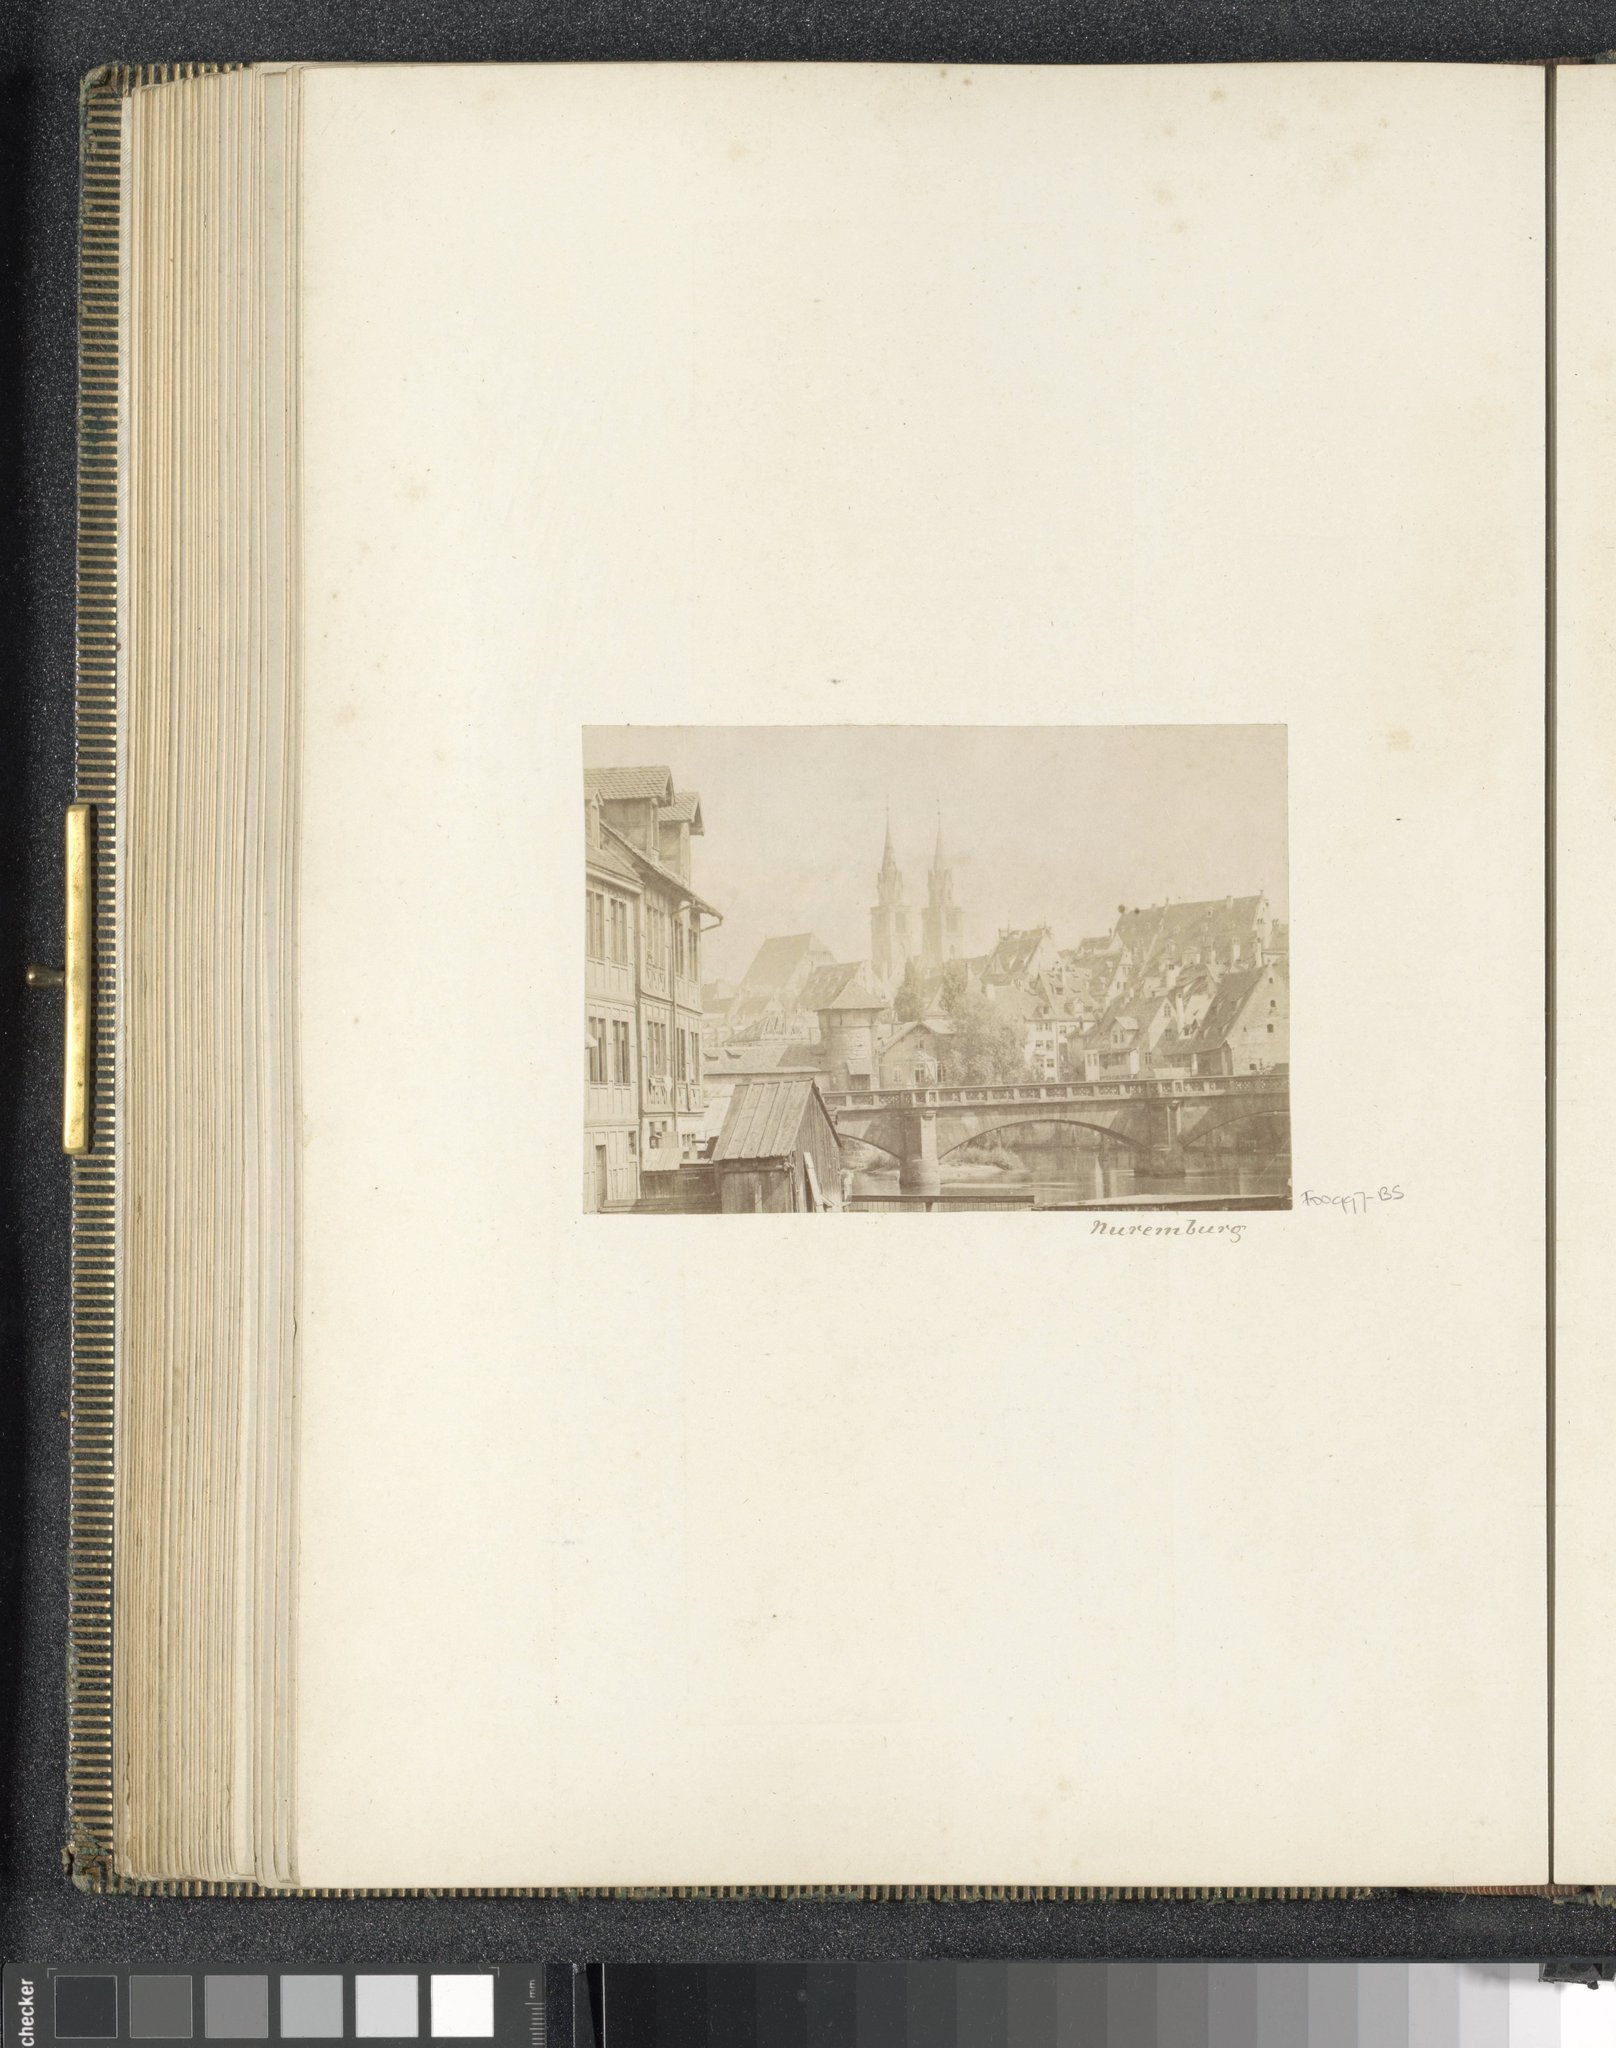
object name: photograph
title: Nuremberg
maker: Anonymous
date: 1860-1890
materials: paper, photographic support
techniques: albumen print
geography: nuremberg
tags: bridge in city across river, canal, etc., prospect of city, town panorama, silhouette of city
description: Onderdeel van Reisalbum met foto's van Zwitserland, Oostenrijk, Italië en Duitsland.